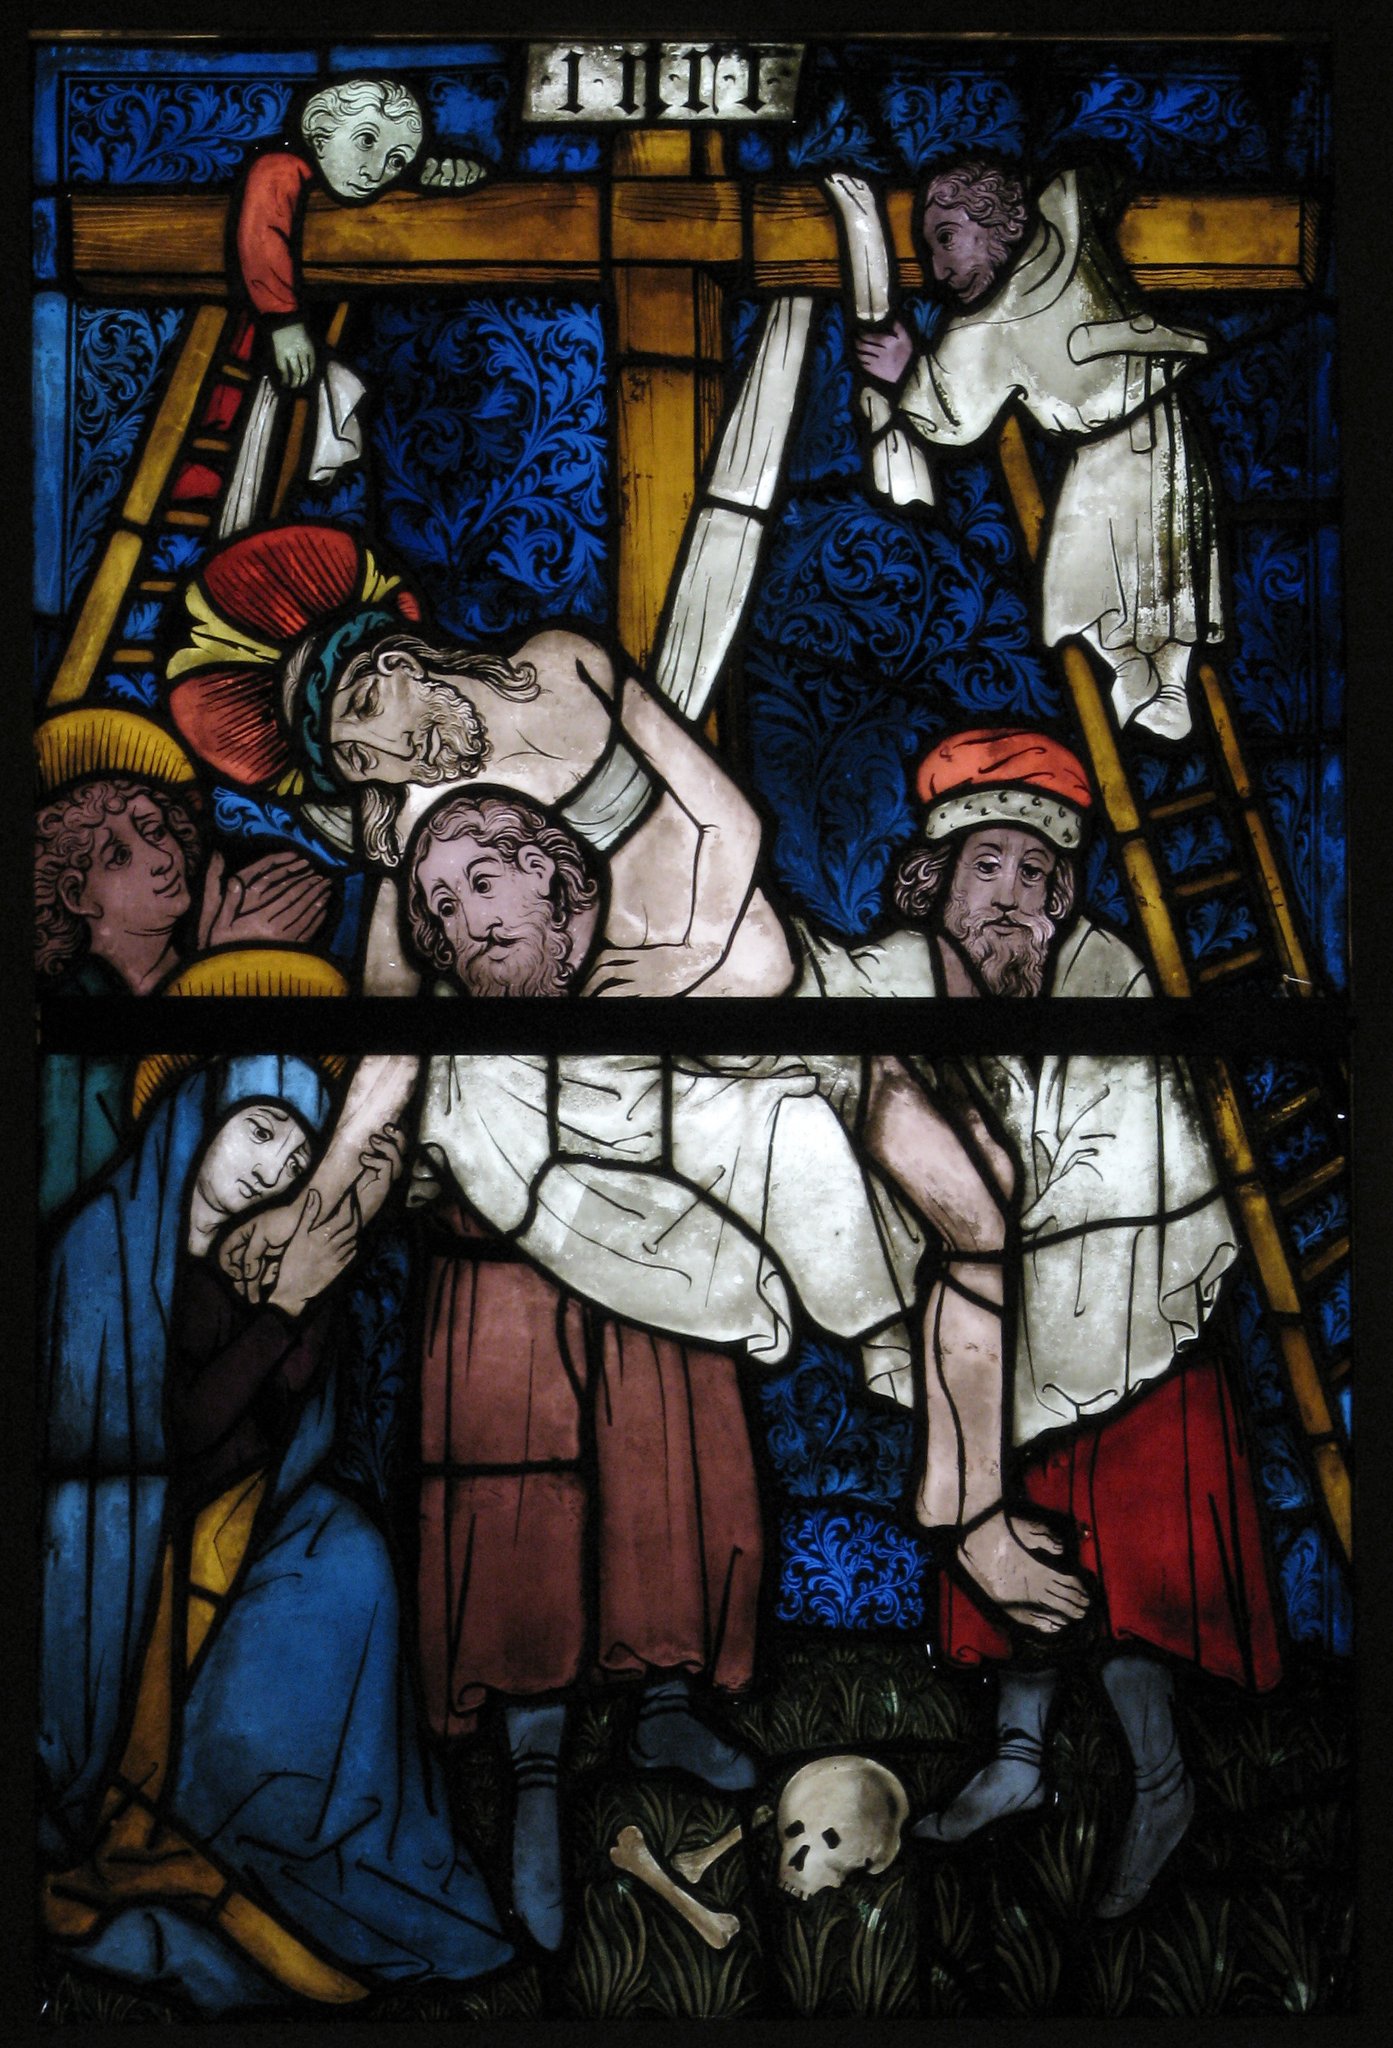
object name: panel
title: Stained Glass Panel with the Deposition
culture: german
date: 1401-1500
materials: glass, metal, paint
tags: skulls,christ,virgin mary,descent from the cross